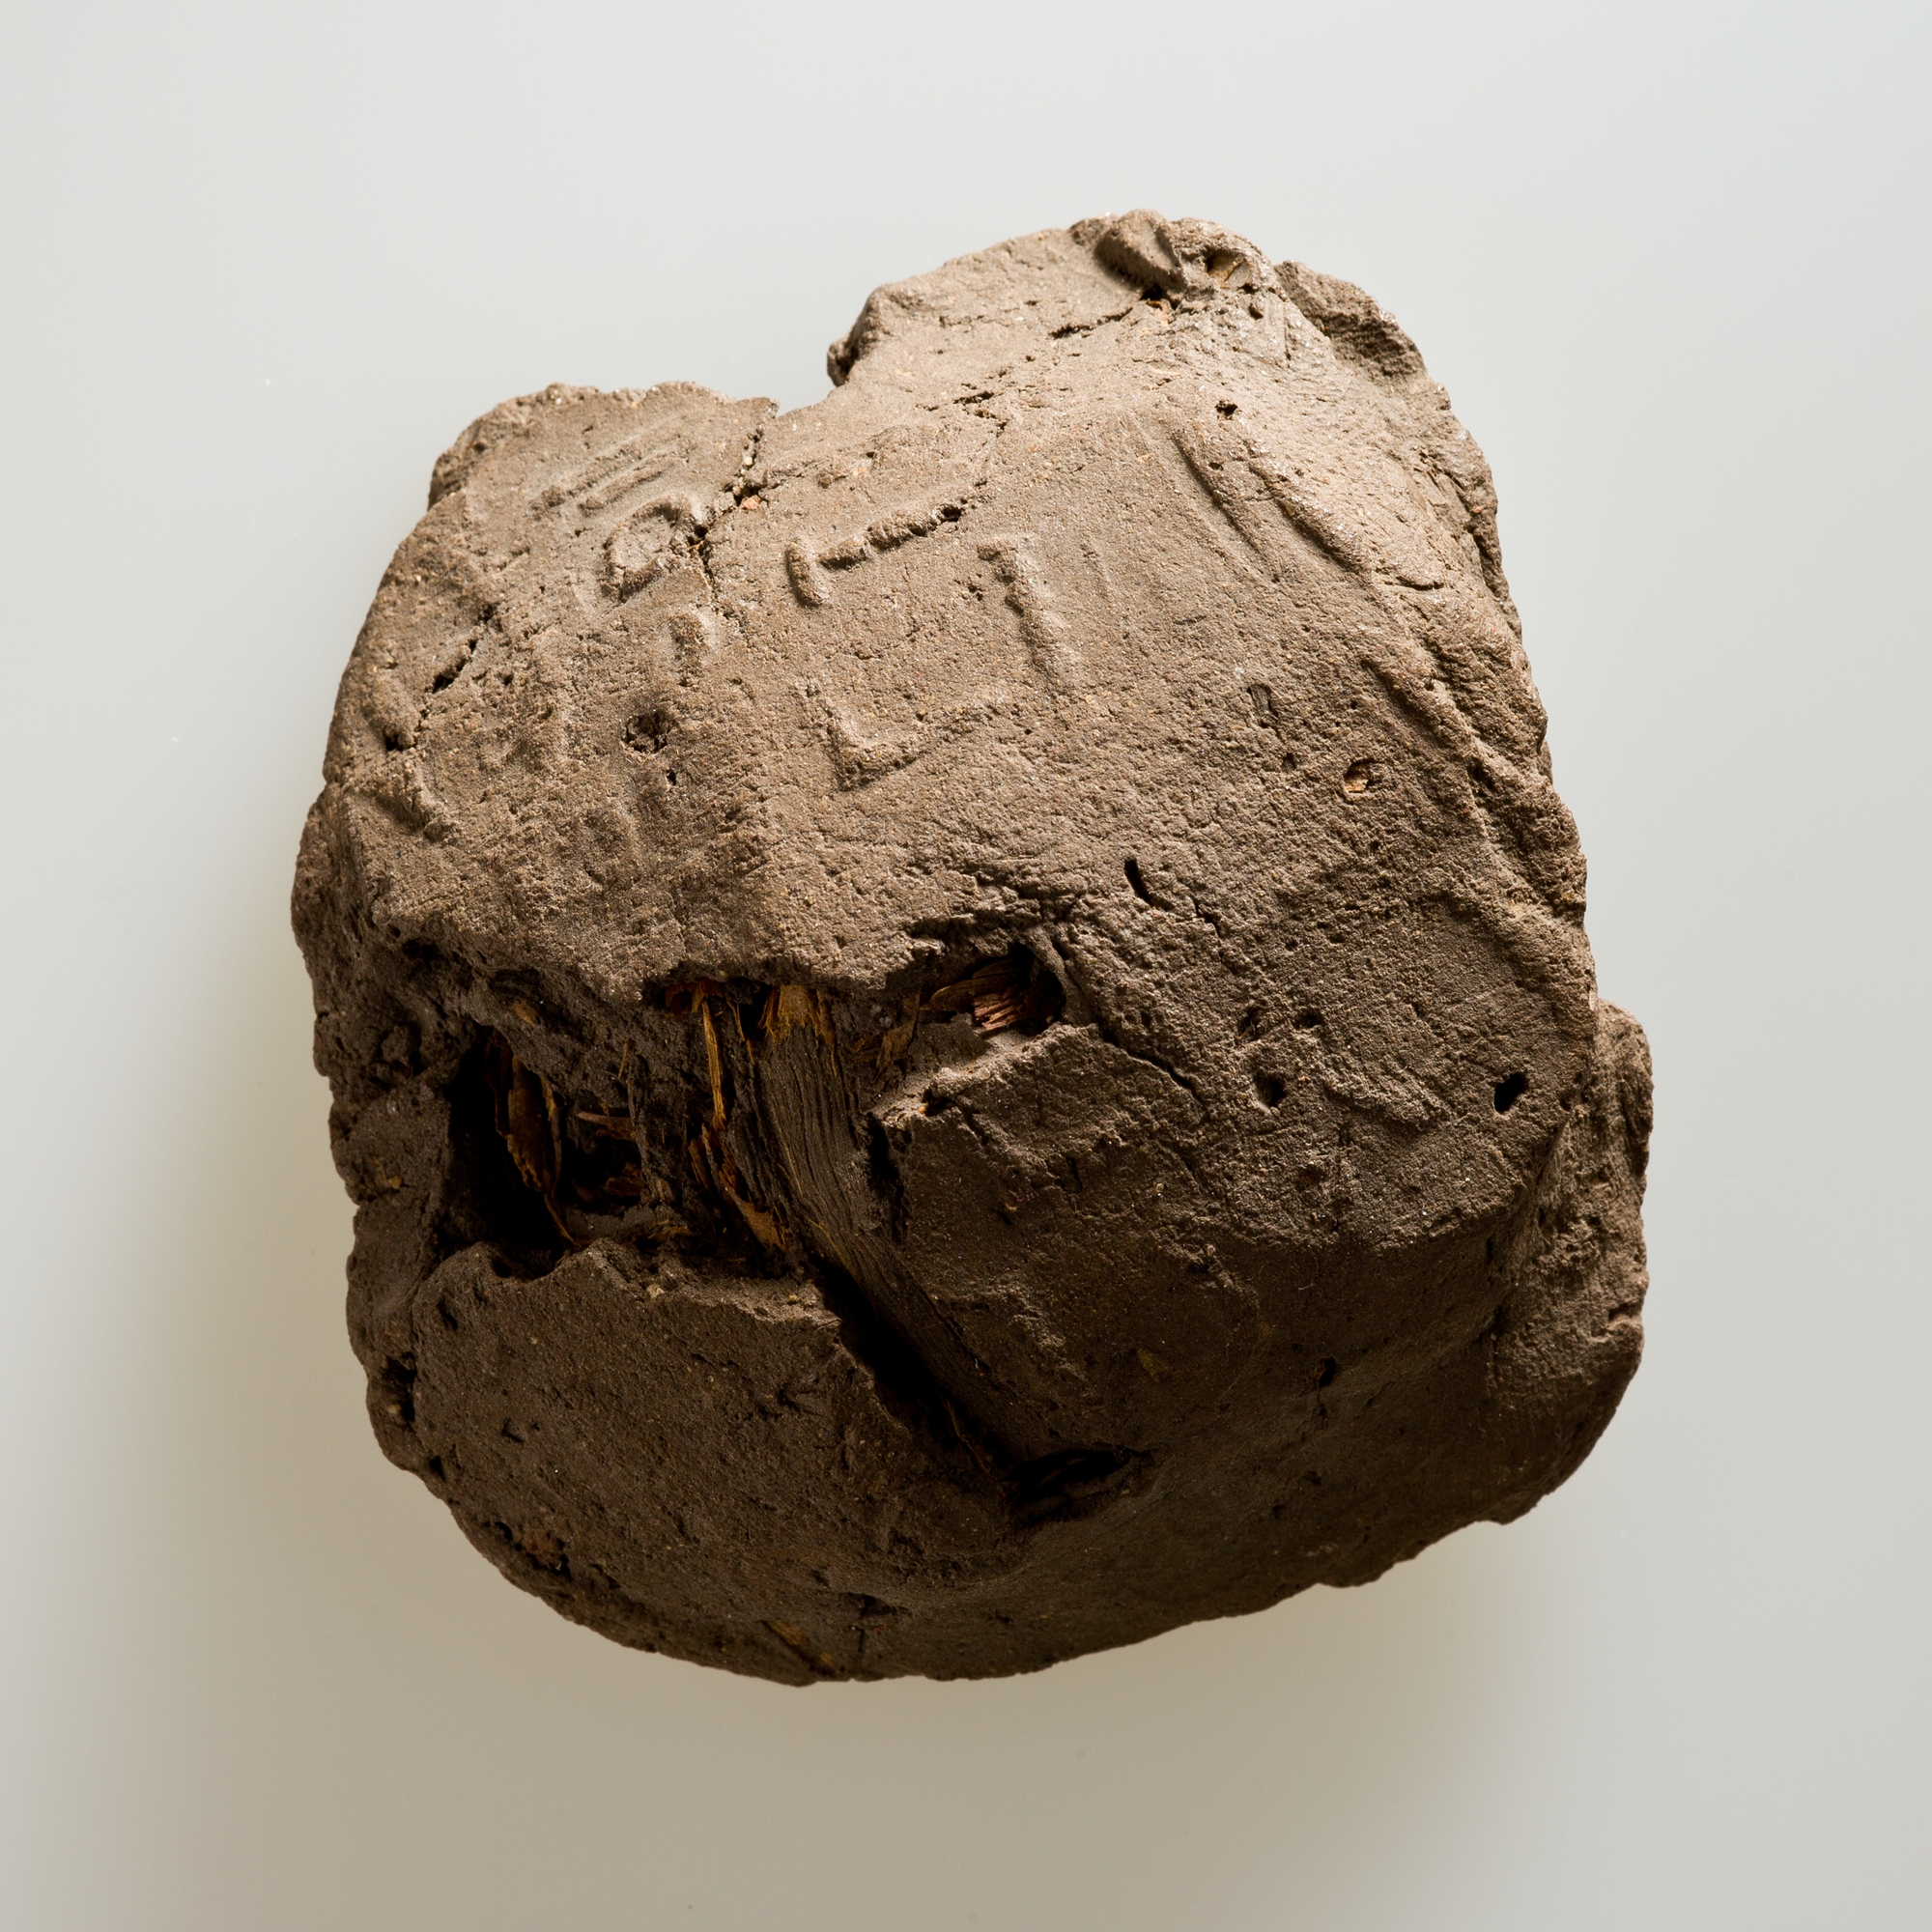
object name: sealing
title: Jar sealing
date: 2650 BCE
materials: clay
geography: egypt